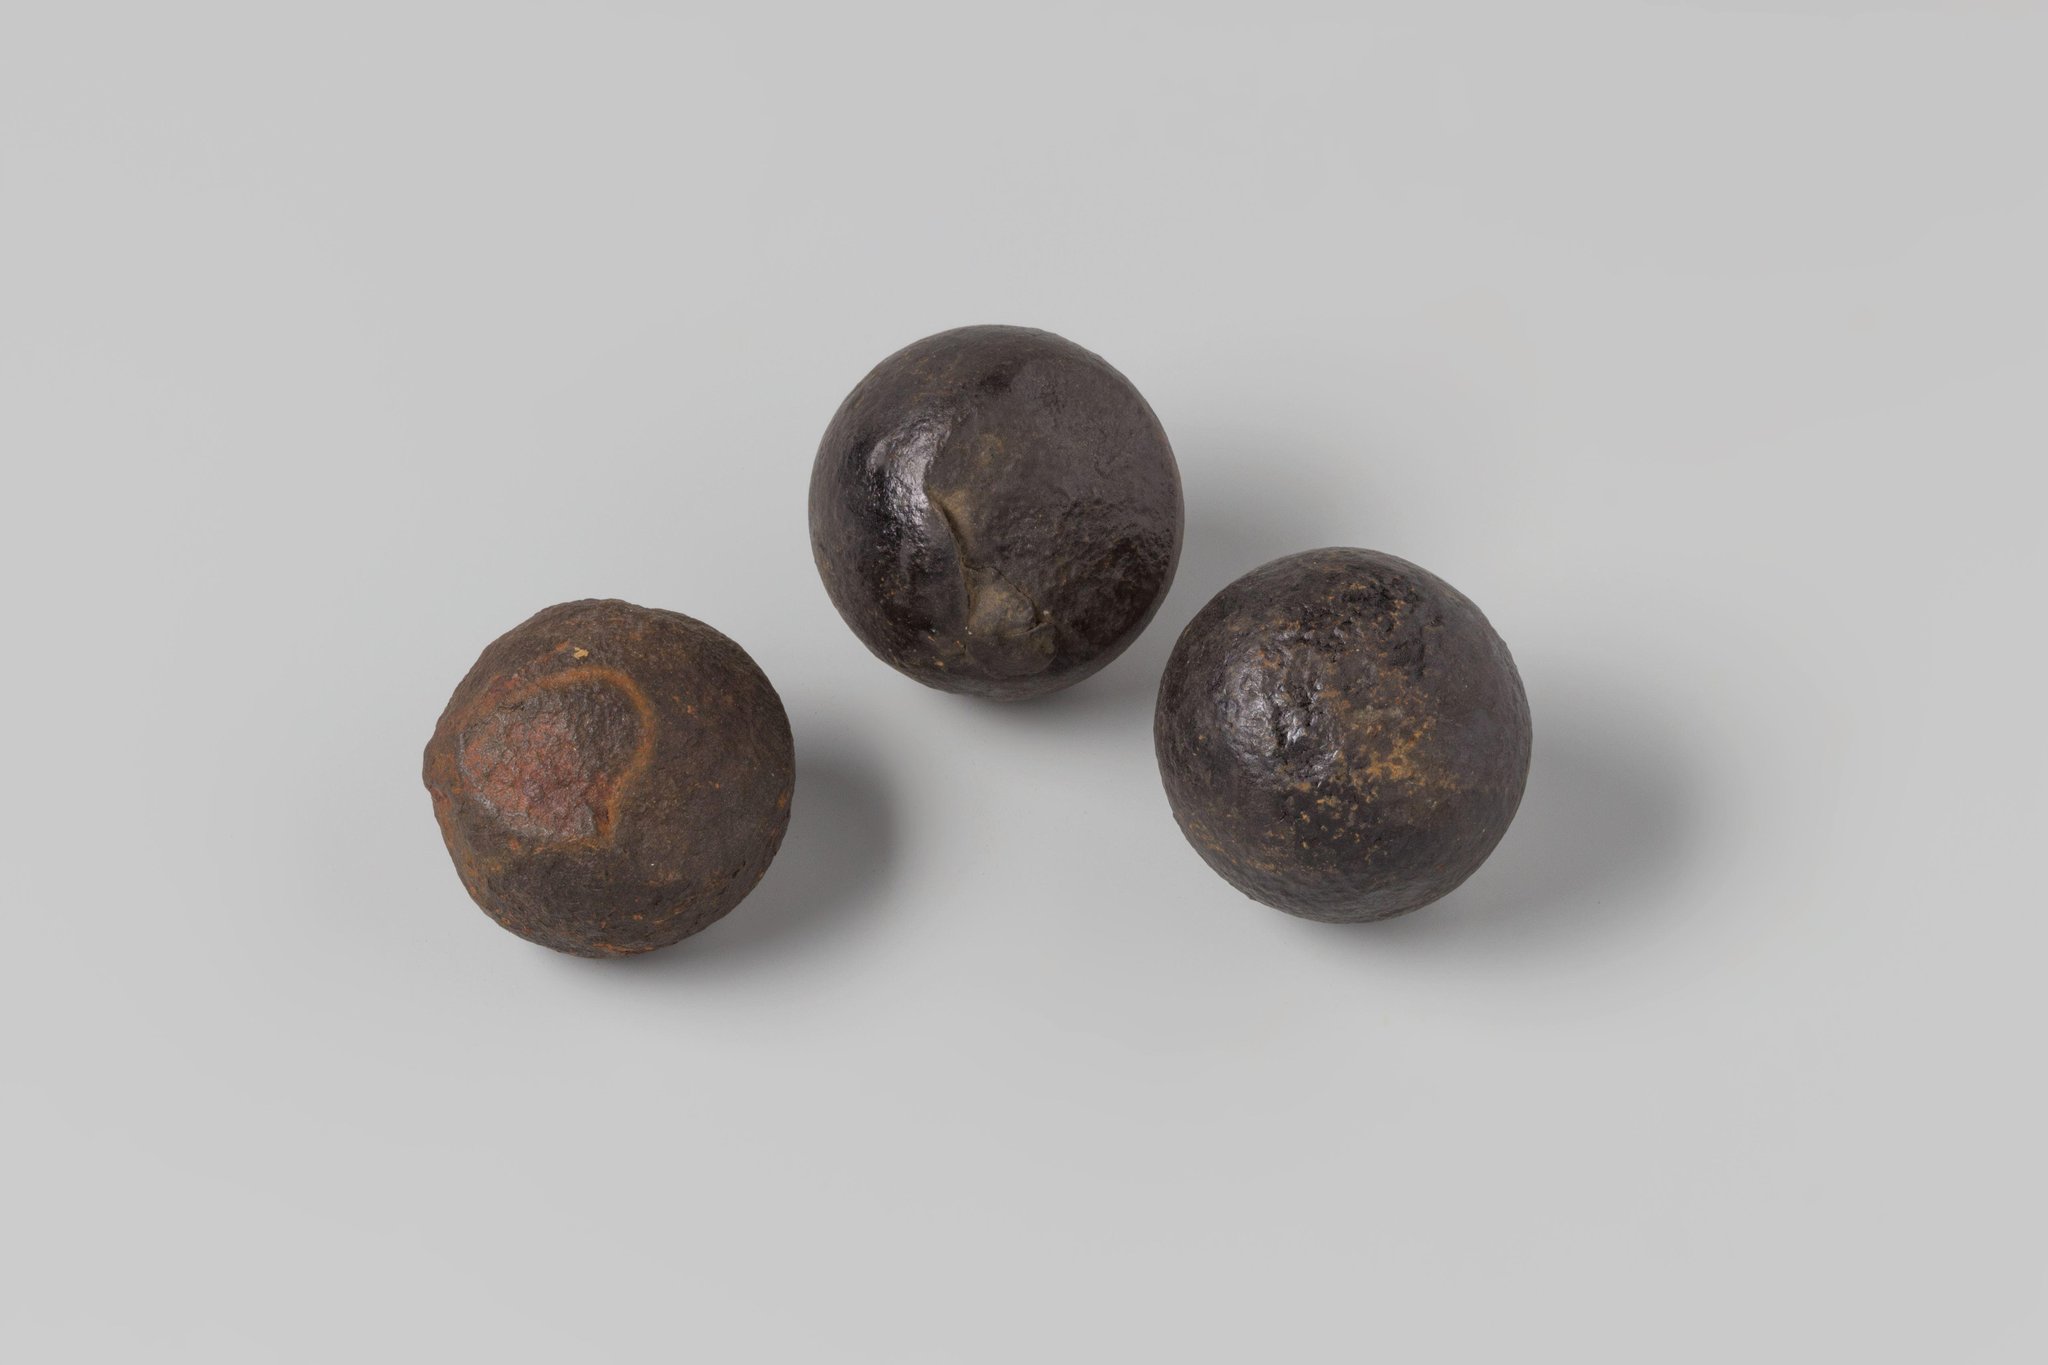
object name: bullet ammunition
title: Kogels uit het wrak van de Oost-Indiëvaarder Hollandia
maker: Anonymous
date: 1700-1743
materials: iron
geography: netherlands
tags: verenigde oostindische compagnie, hollandia (schip), annet